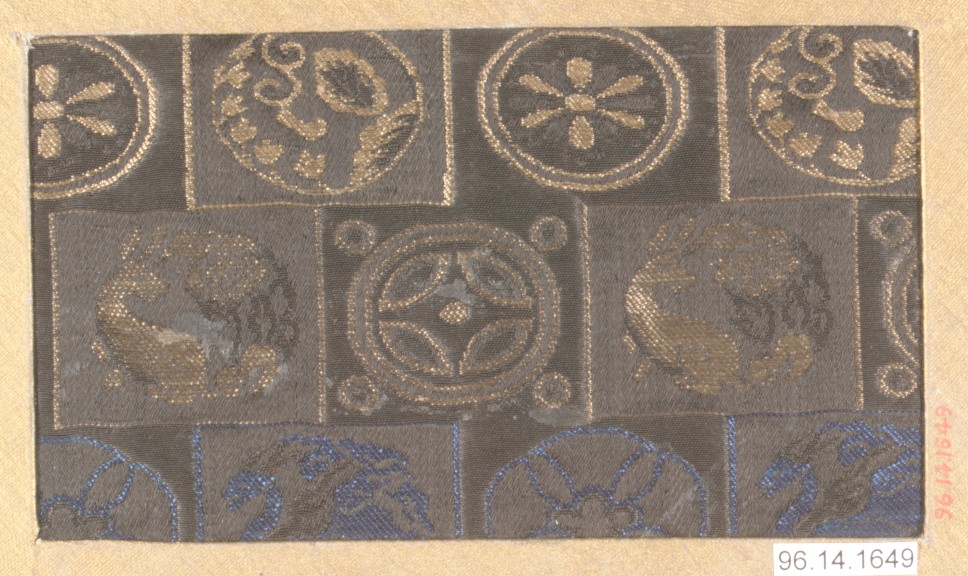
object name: piece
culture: japanese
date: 1701-1900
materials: silk